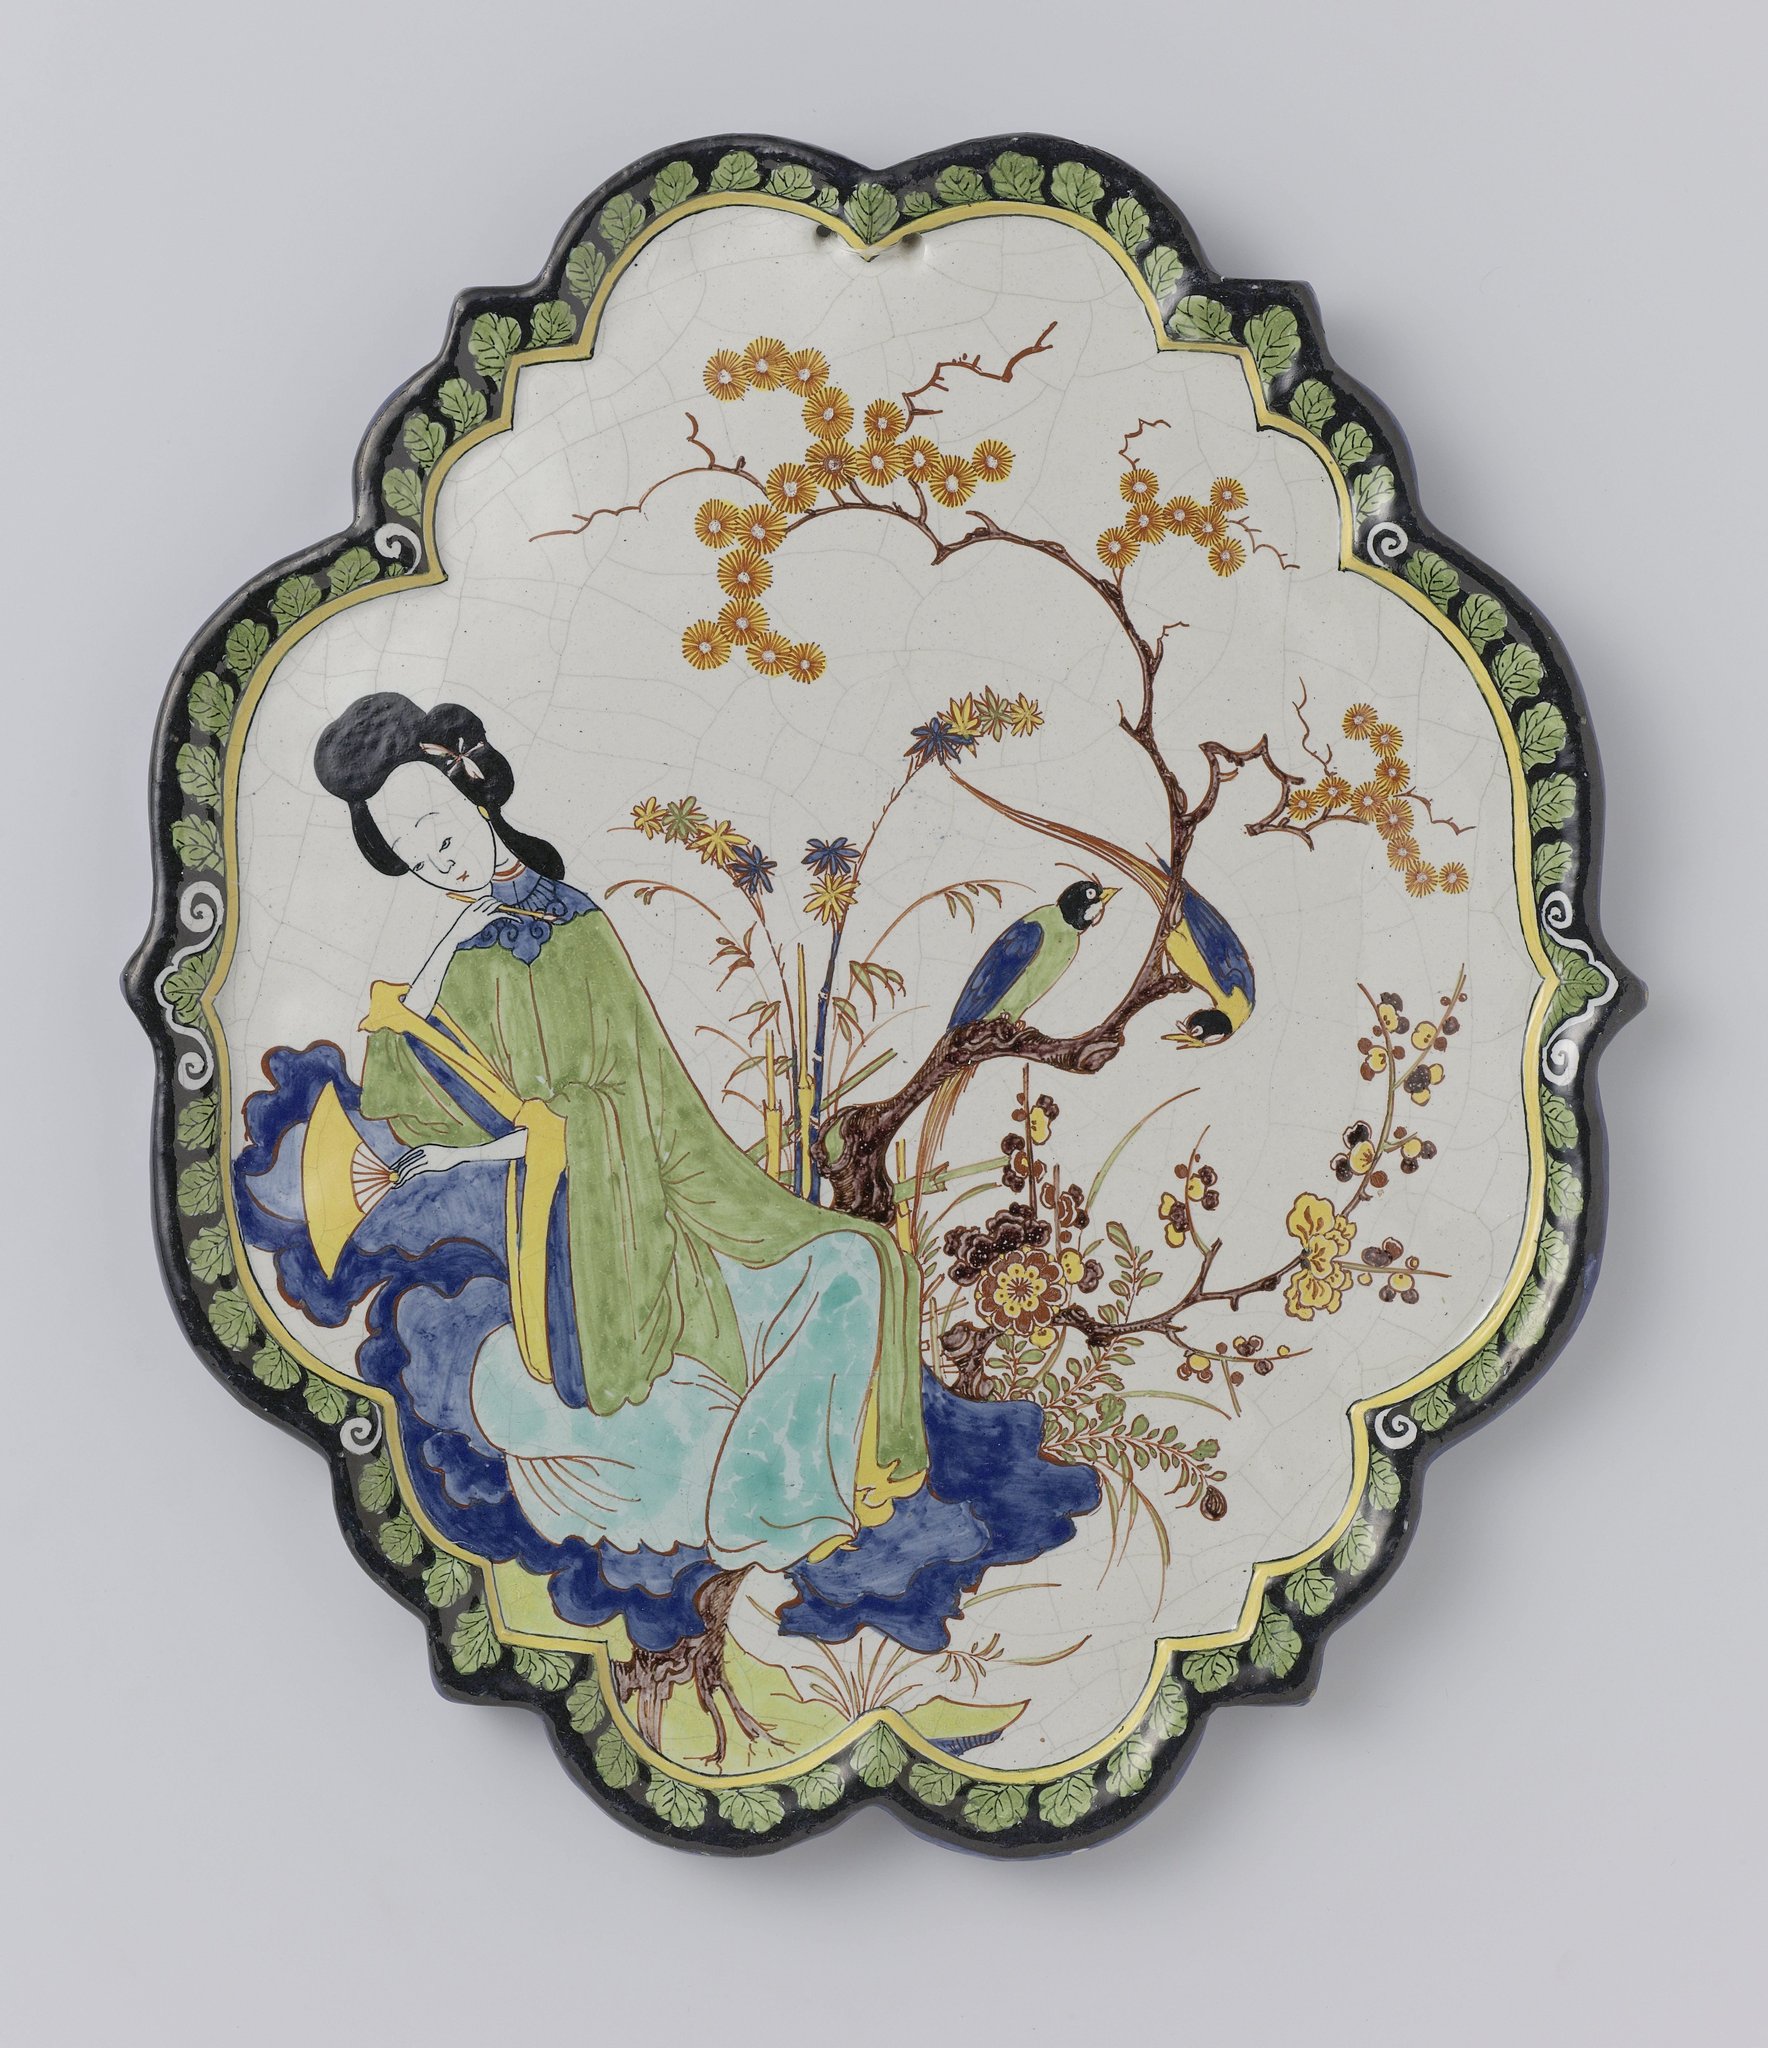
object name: plate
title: Plaque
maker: Anonymous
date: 1725-1740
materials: earthenware, glaze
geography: delft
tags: chinese (+ other cultural aspects)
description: Plaat van faience. Veelkleurig beschilderd met een chinese vrouw in een tuin.